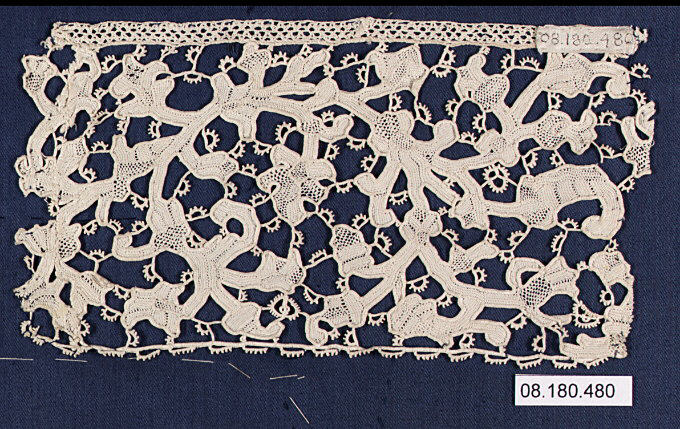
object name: fragment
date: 1665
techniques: lace